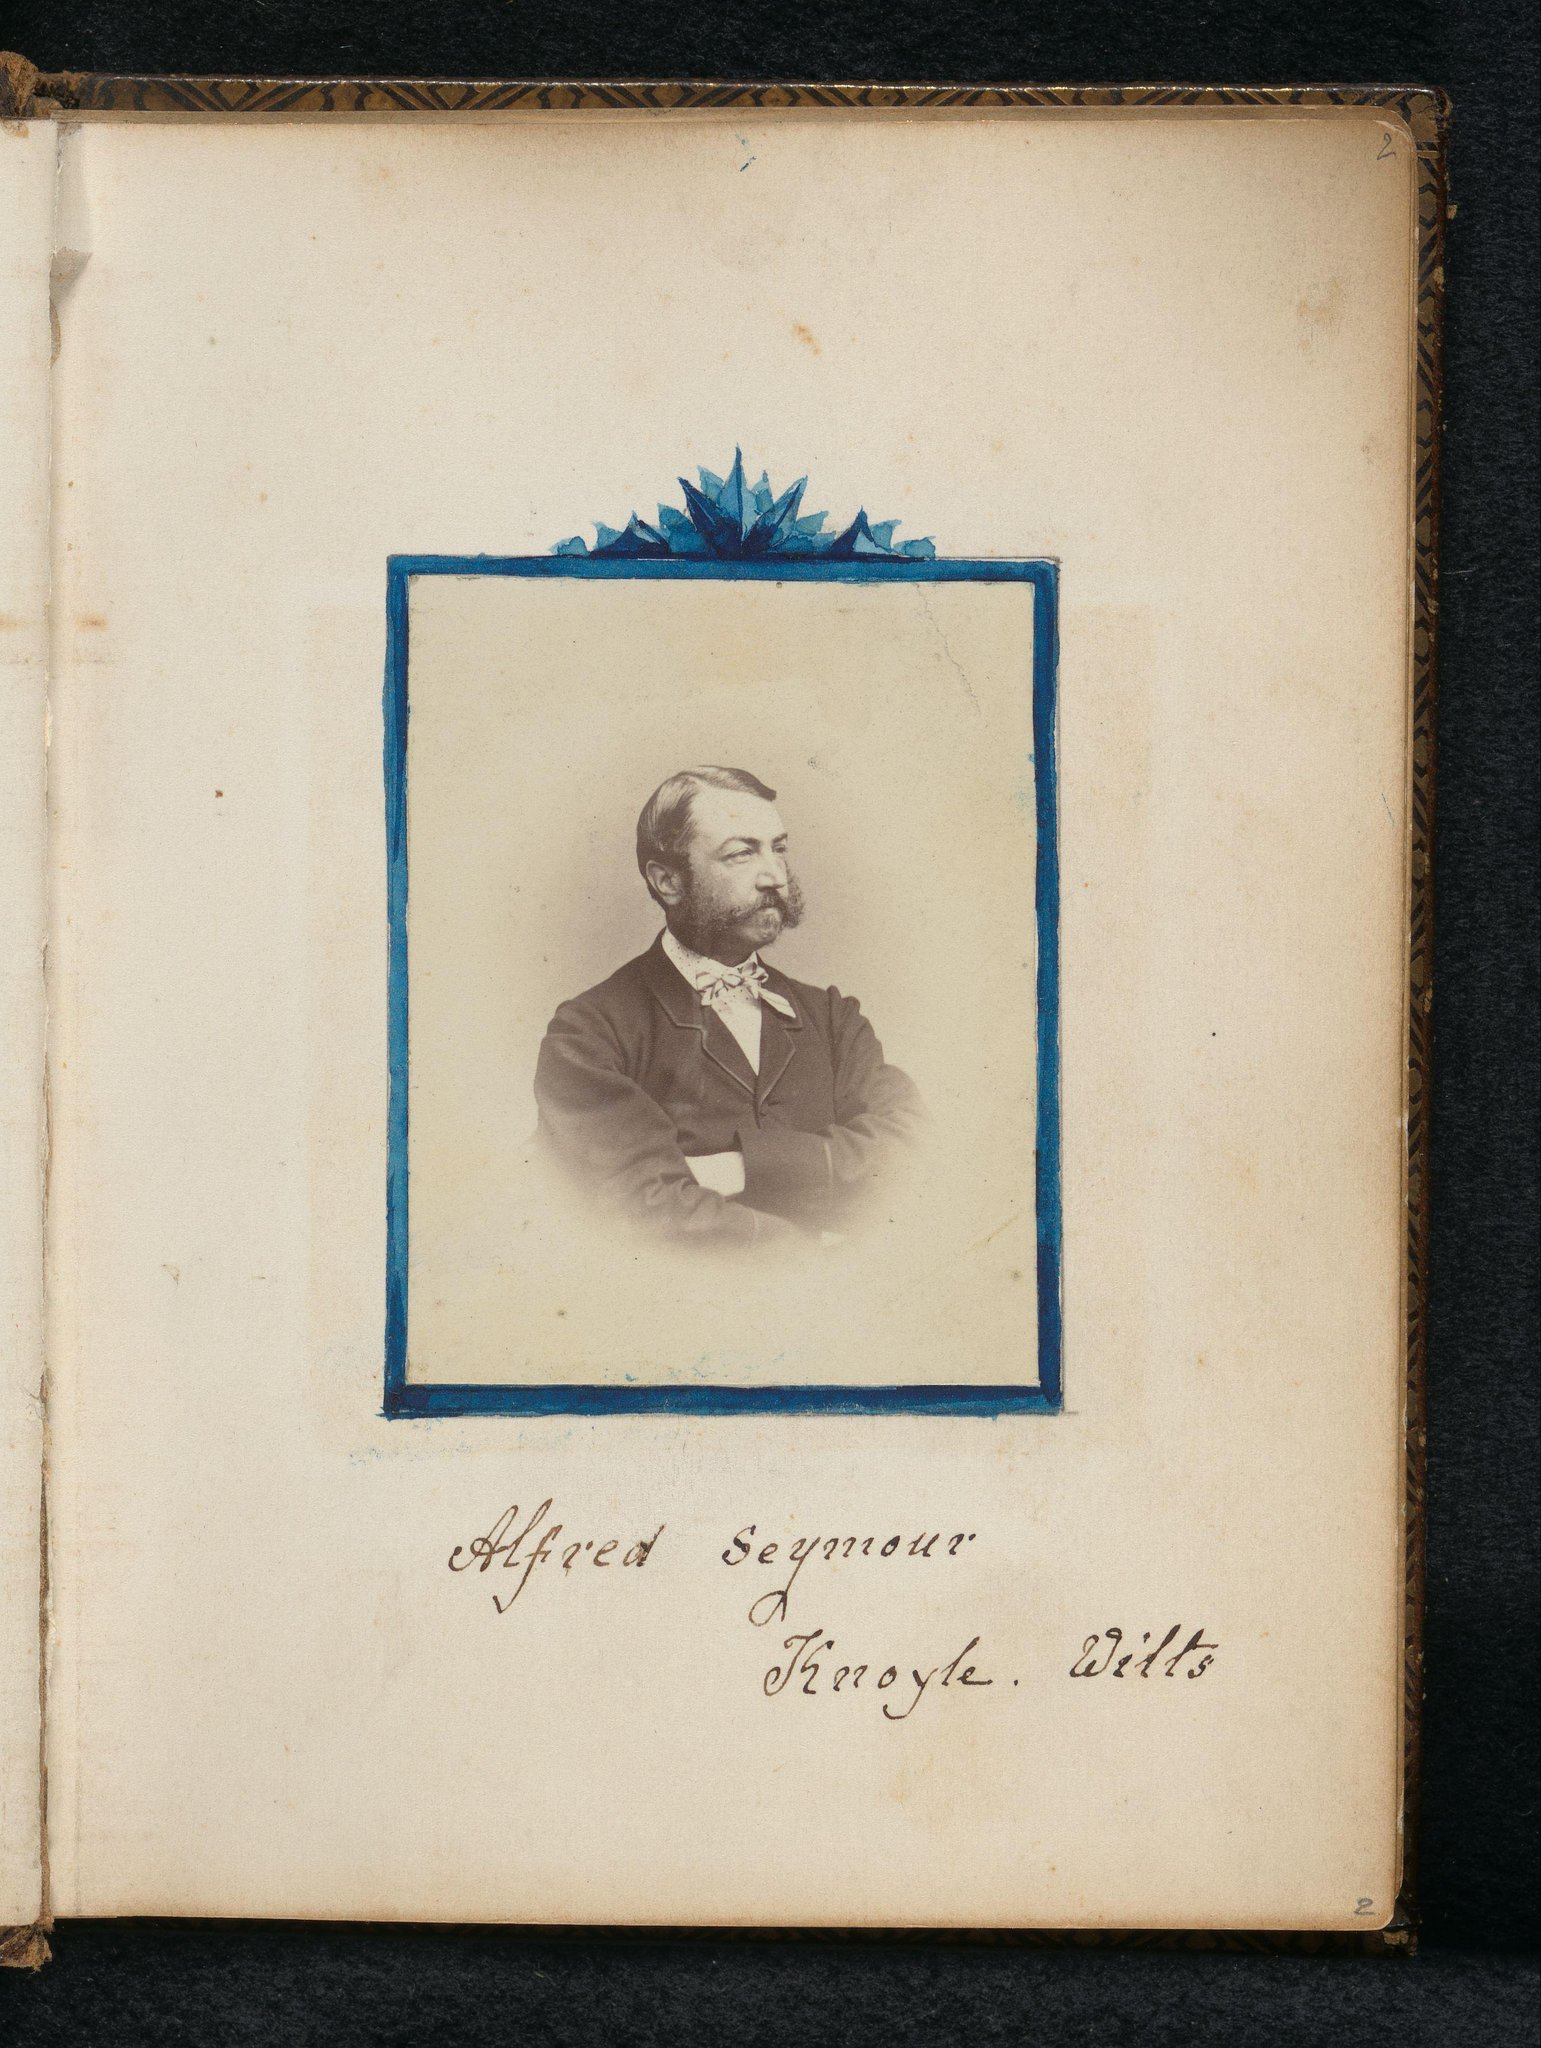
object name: photograph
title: Alfred Seymour / Knoyle Wilts.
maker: Anonymous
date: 1865-1867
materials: cardboard, photographic support, watercolor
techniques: albumen print, aquarelle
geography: england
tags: historical persons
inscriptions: annotation: ‘Alfred Seymour / Knoyle Wilts.’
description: Portret van de politicus Alfred Seymour. Foto op albumblad in album met 68 foto's merendeels met geaquarelleerde randversieringen. Het zijn voornamelijk portretten op carte-de-visite formaat.